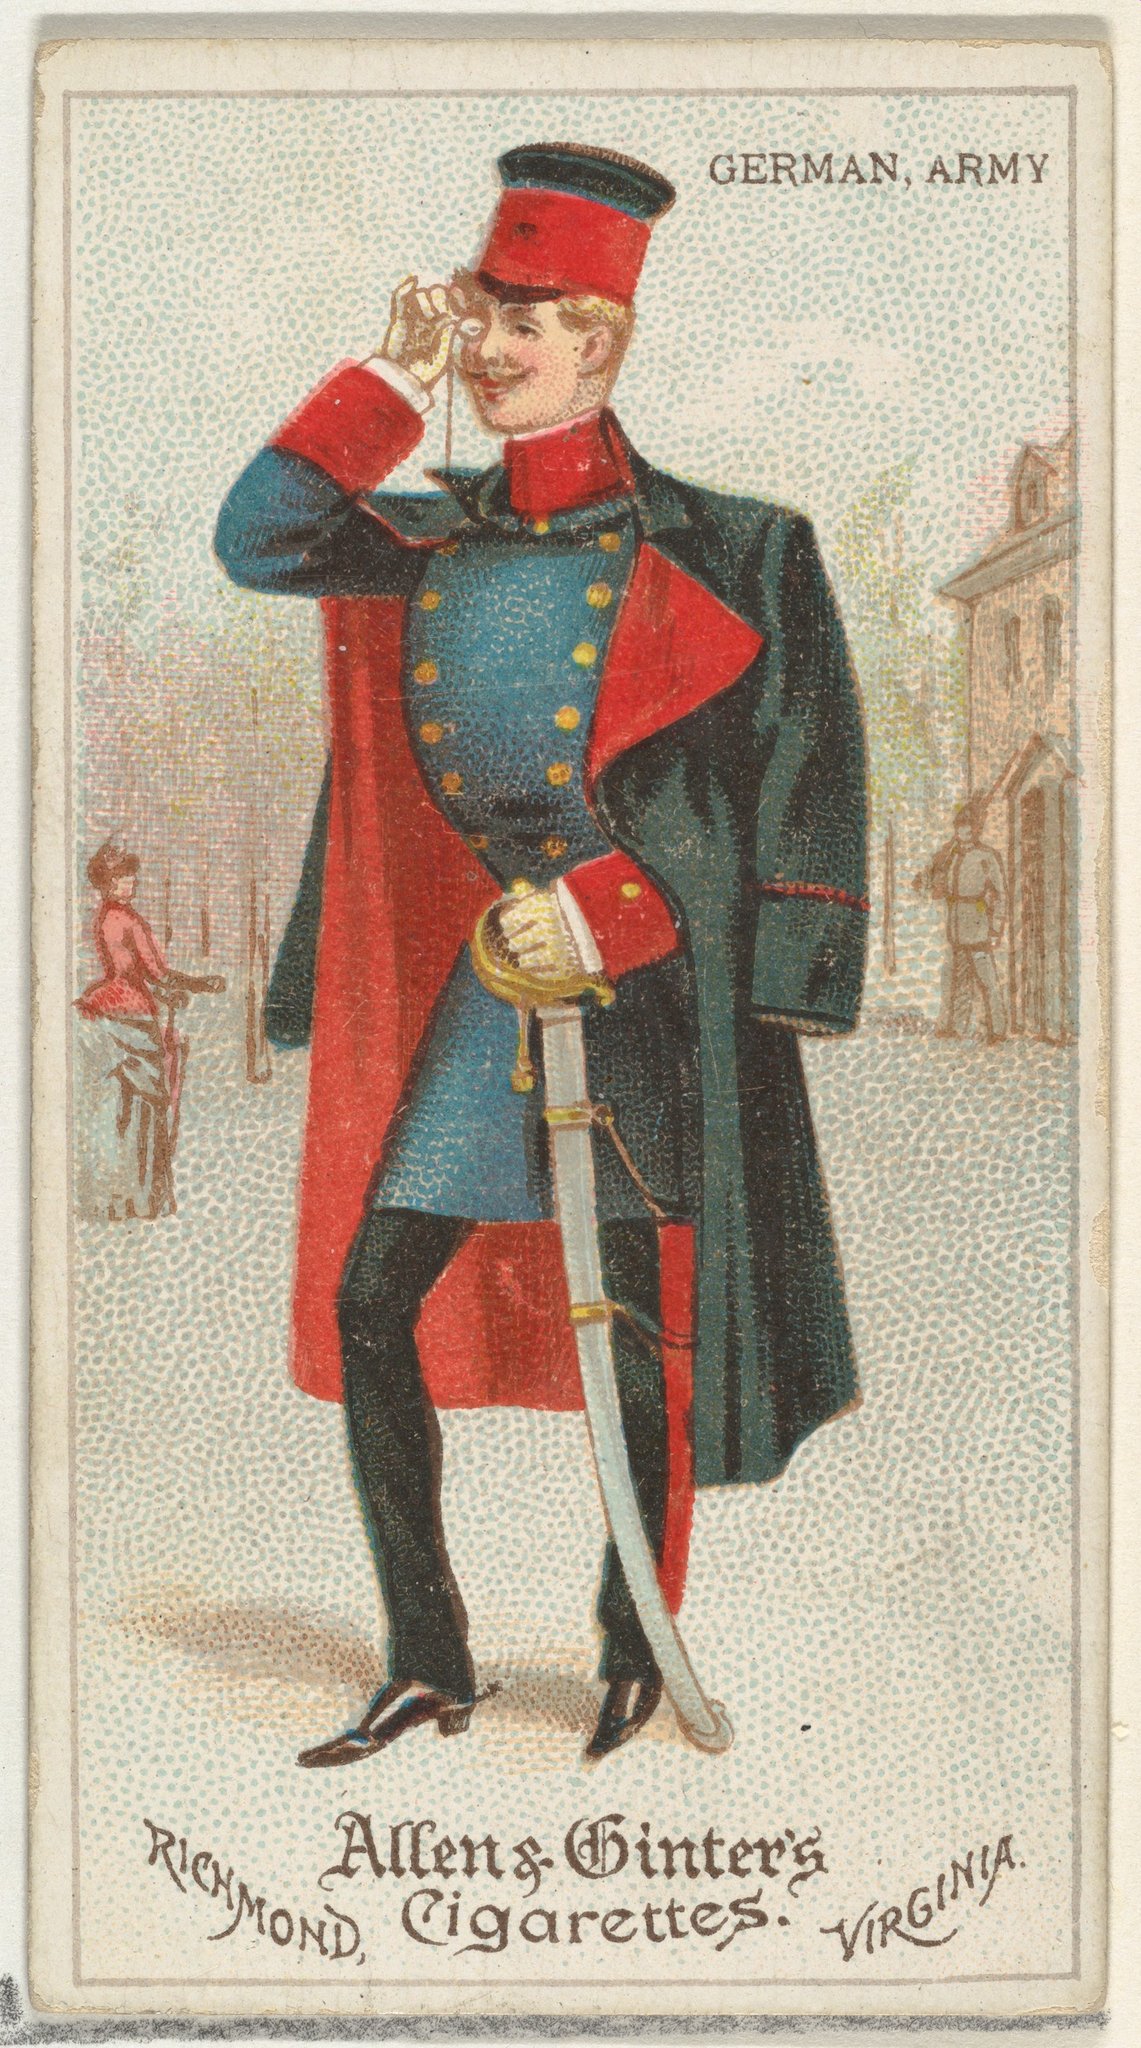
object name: print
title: German, Army, from World's Dudes series (N31) for Allen & Ginter Cigarettes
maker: allen & ginter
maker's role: publisher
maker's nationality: american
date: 1888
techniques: color lithograph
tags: men